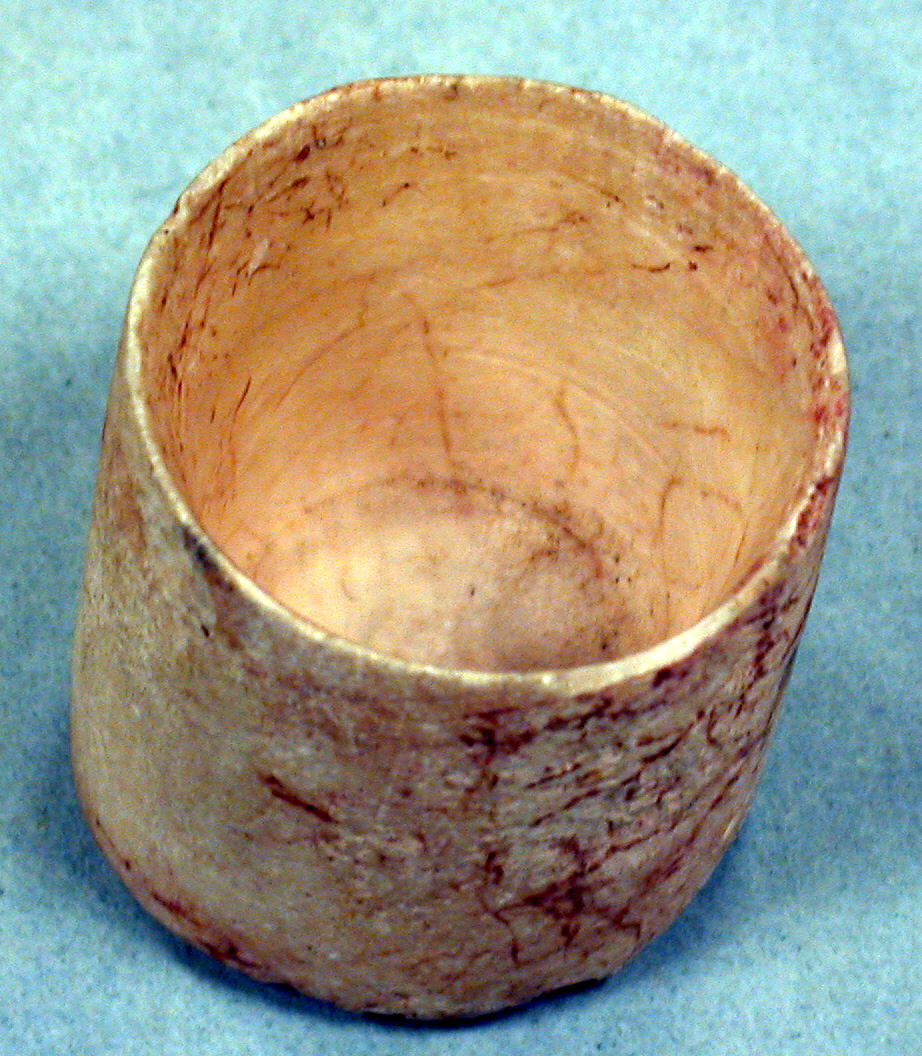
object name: vessel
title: Stone Cylinder Vessel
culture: mexican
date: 1501-1600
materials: stone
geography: mexico